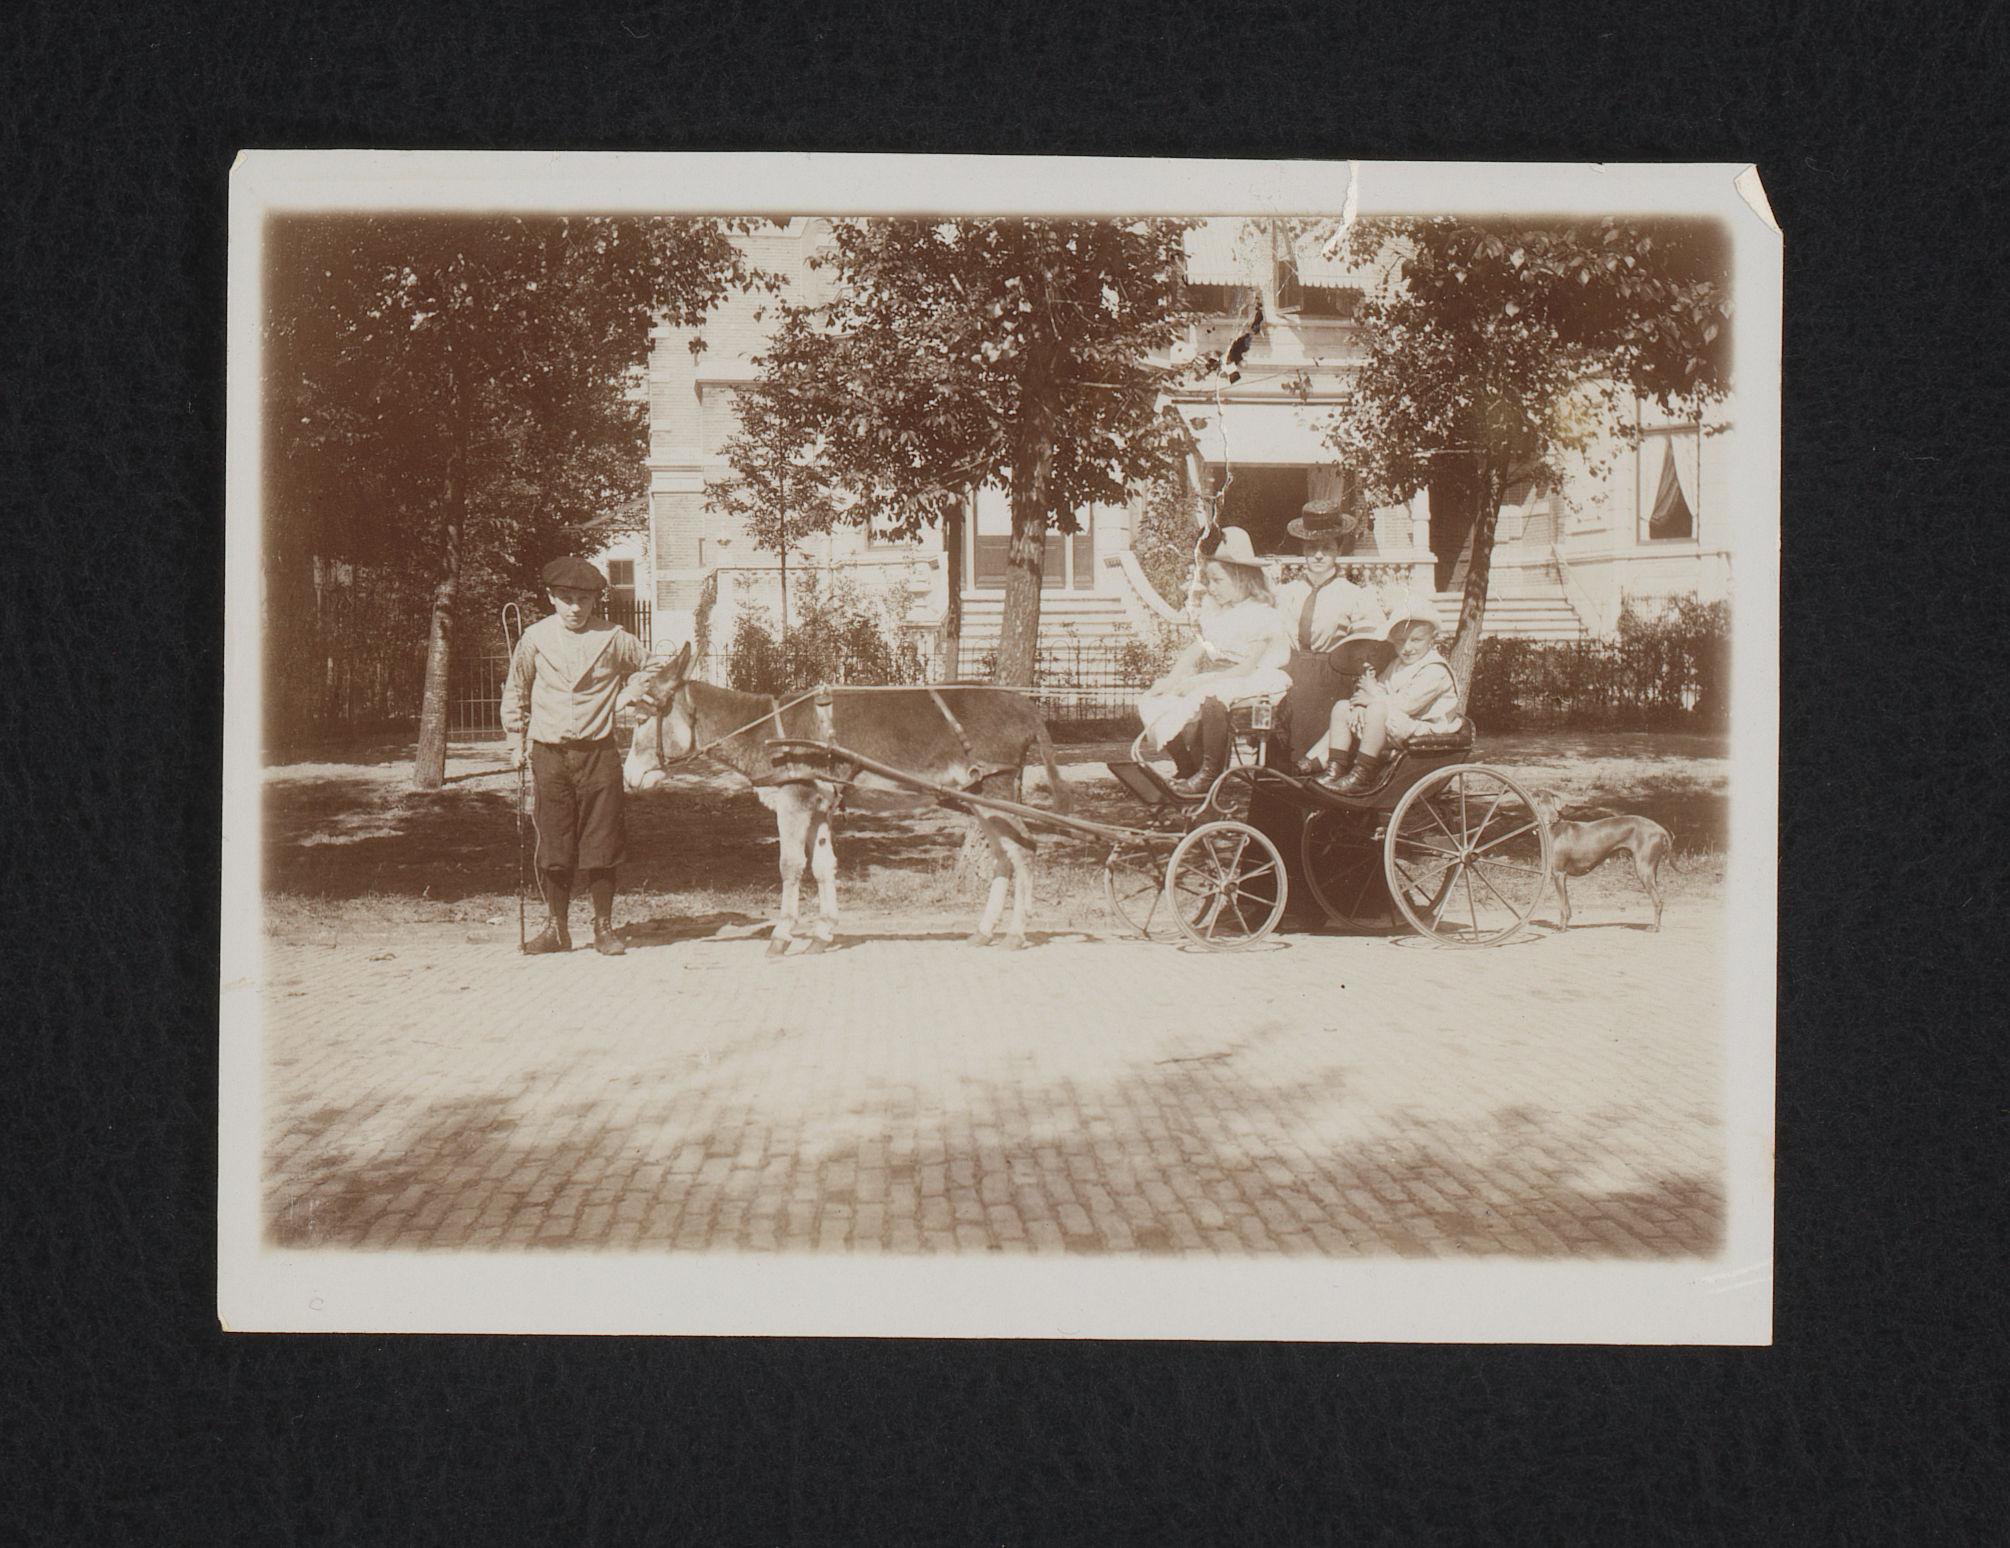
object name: photograph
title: Jongen bij ezelwagen met drie kinderen en een vrouw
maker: Anonymous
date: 1880-1910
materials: photographic support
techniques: collodion silver print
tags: passenger carriage, mother and child(ren), woman and child(ren) (family group)